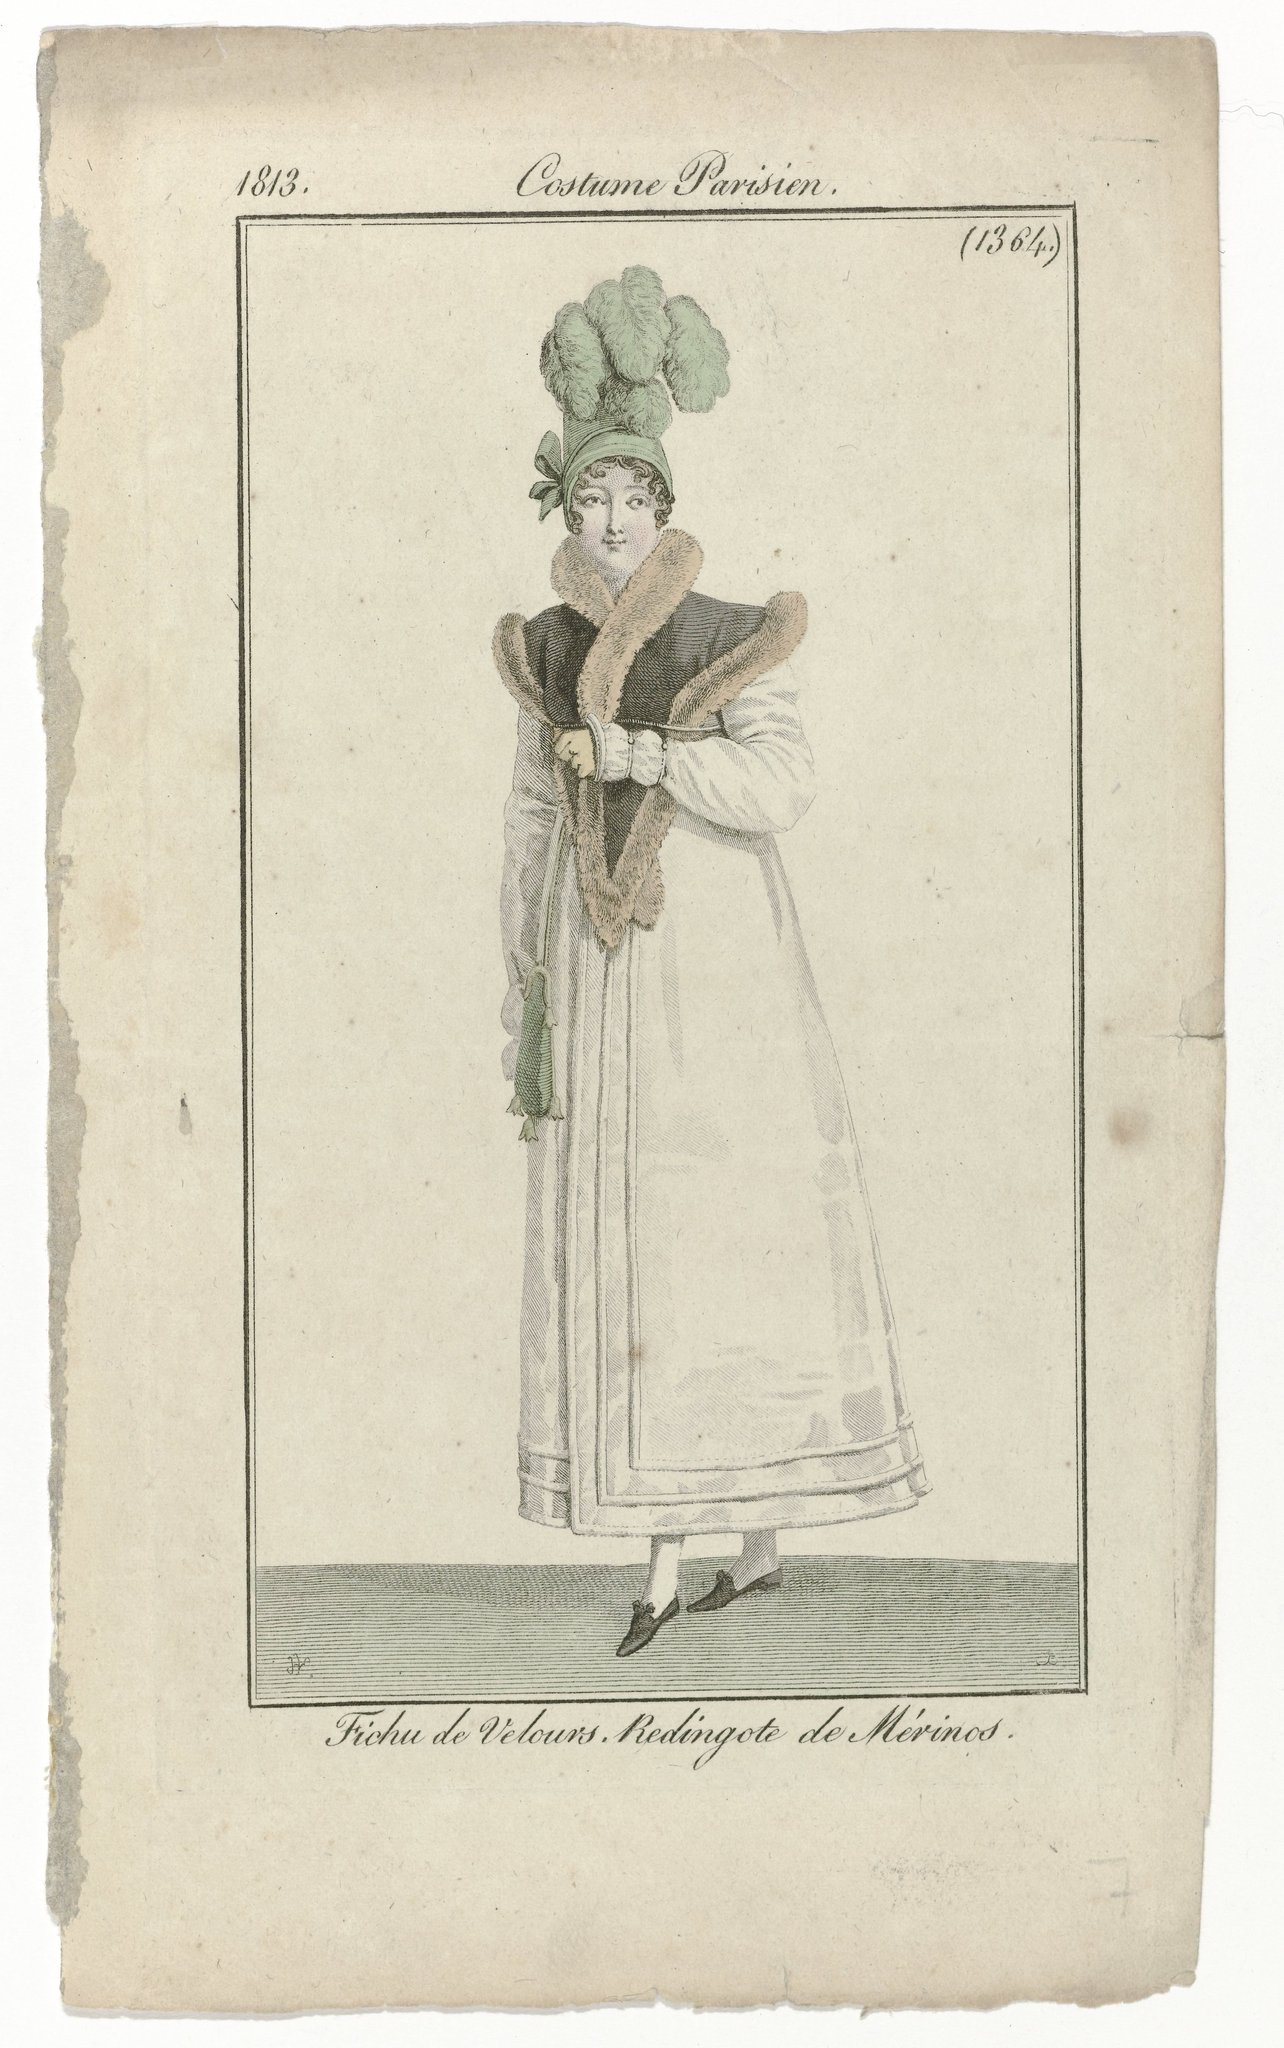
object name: fashion print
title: Journal des Dames et des Modes: Ladies’ Fashion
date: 1813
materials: paper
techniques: engraving, hand coloring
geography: paris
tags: bag (reticule) (+ women's clothes), dress, gown: redingote (+ women's clothes), border, ribbon, braid (+ fur used for clothes), fashion plates, head-gear: hat (+ women's clothes), shoes, sandals (+ women's clothes), gloves, mittens, etc. (+ women's clothes), piece of clothing covering the breast or décolleté (fichu) (+ women's clothes)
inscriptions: caption: ‘Fichu de Velours. Redingote de Mérinos.’, title: ‘Costume Parisien.’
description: After the turbulent years of the French Revolution, in 1797 a fashion magazine was finally published again: the Journal des Dames et des Modes. Under the direction of Pierre de La Mésangère, it developed a cosmopolitan flair. The very best draughtsmen were recruited to produce the fashion illustrations, called Costumes Parisiens. They visited spots all over Paris to ensure they saw the latest styles. These included high-waisted gowns with low necklines, ‘Greek’ slippers with cross-laces 1, genuine Kashmiri shawls 2, reticules 3 (small stylish handbags), poke bonnets 4 and full-length English coats knowns as redingotes 5.